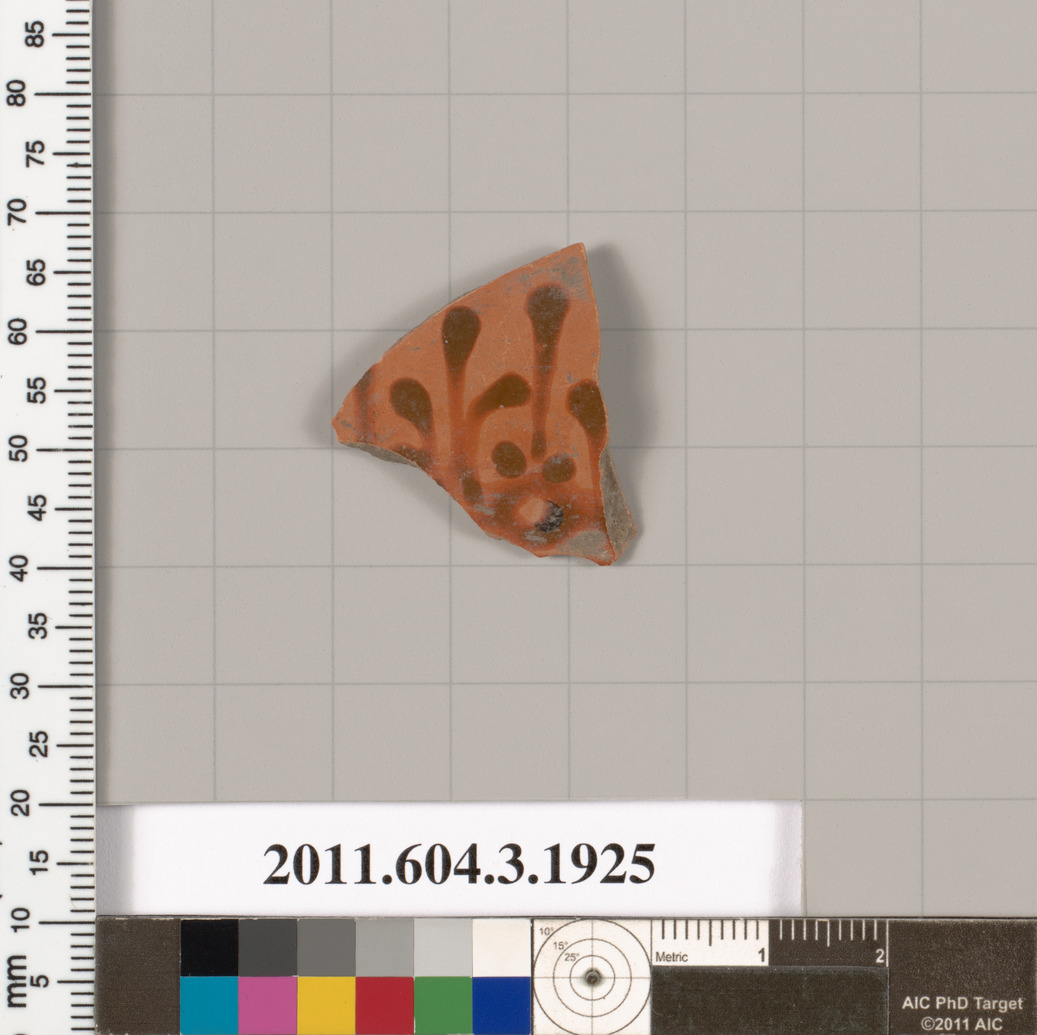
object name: kylix or skyphos fragment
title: Terracotta fragment of a kylix (drinking cup) or a skyphos (deep drinking cup)?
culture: greek, attic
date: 534-468 BCE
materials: terracotta